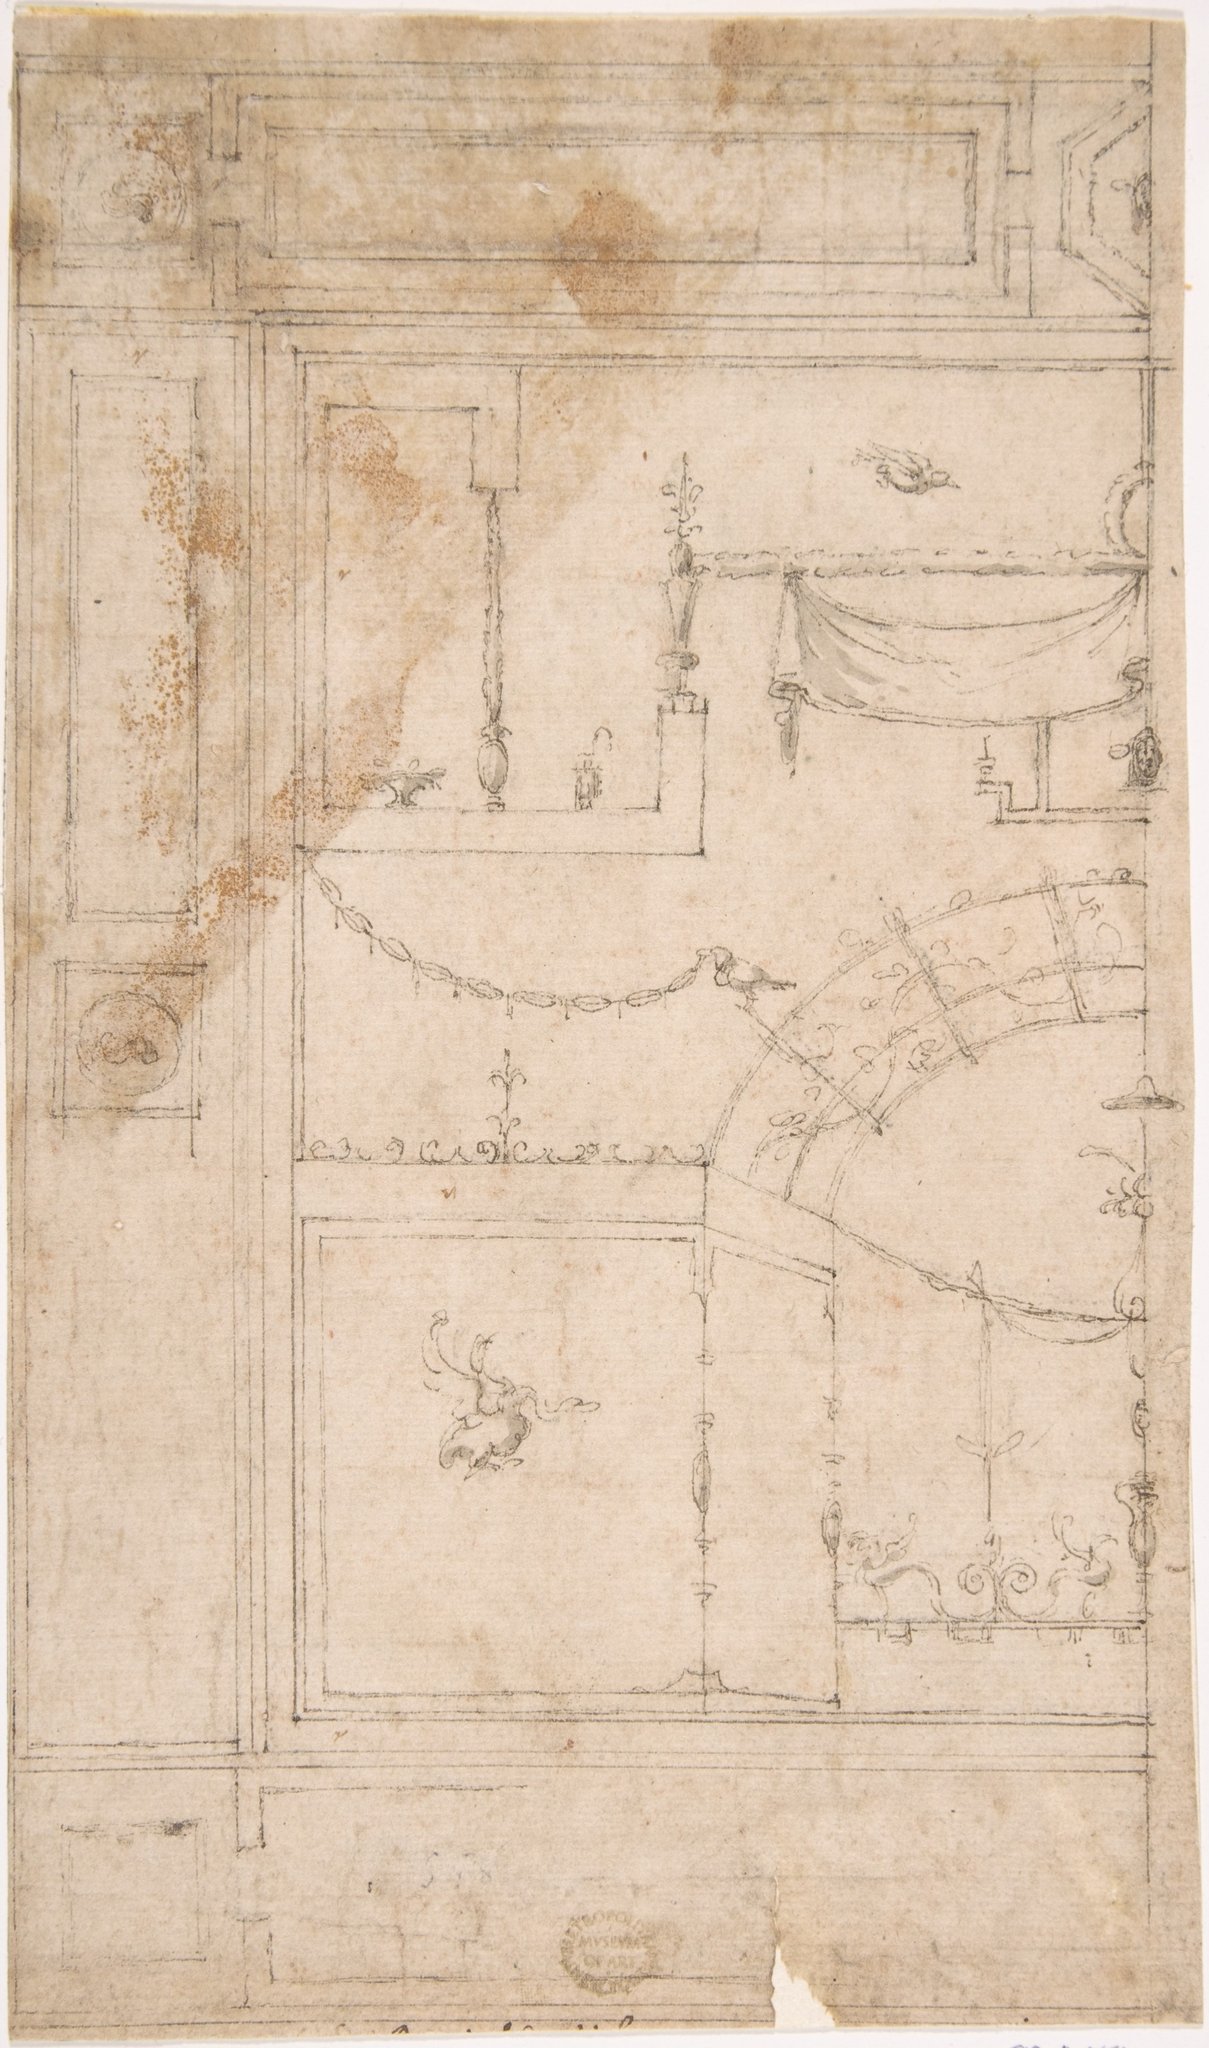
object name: drawing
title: Design for the Decoration of a Wall with Grotteschi in the Antique-Style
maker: luzio luzzi (also known as luzio romano, luzio da todi)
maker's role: artist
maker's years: 1519-1582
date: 1545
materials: chalk, ink, drawing material, paper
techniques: brush, pen, wash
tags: architecture,grotesques